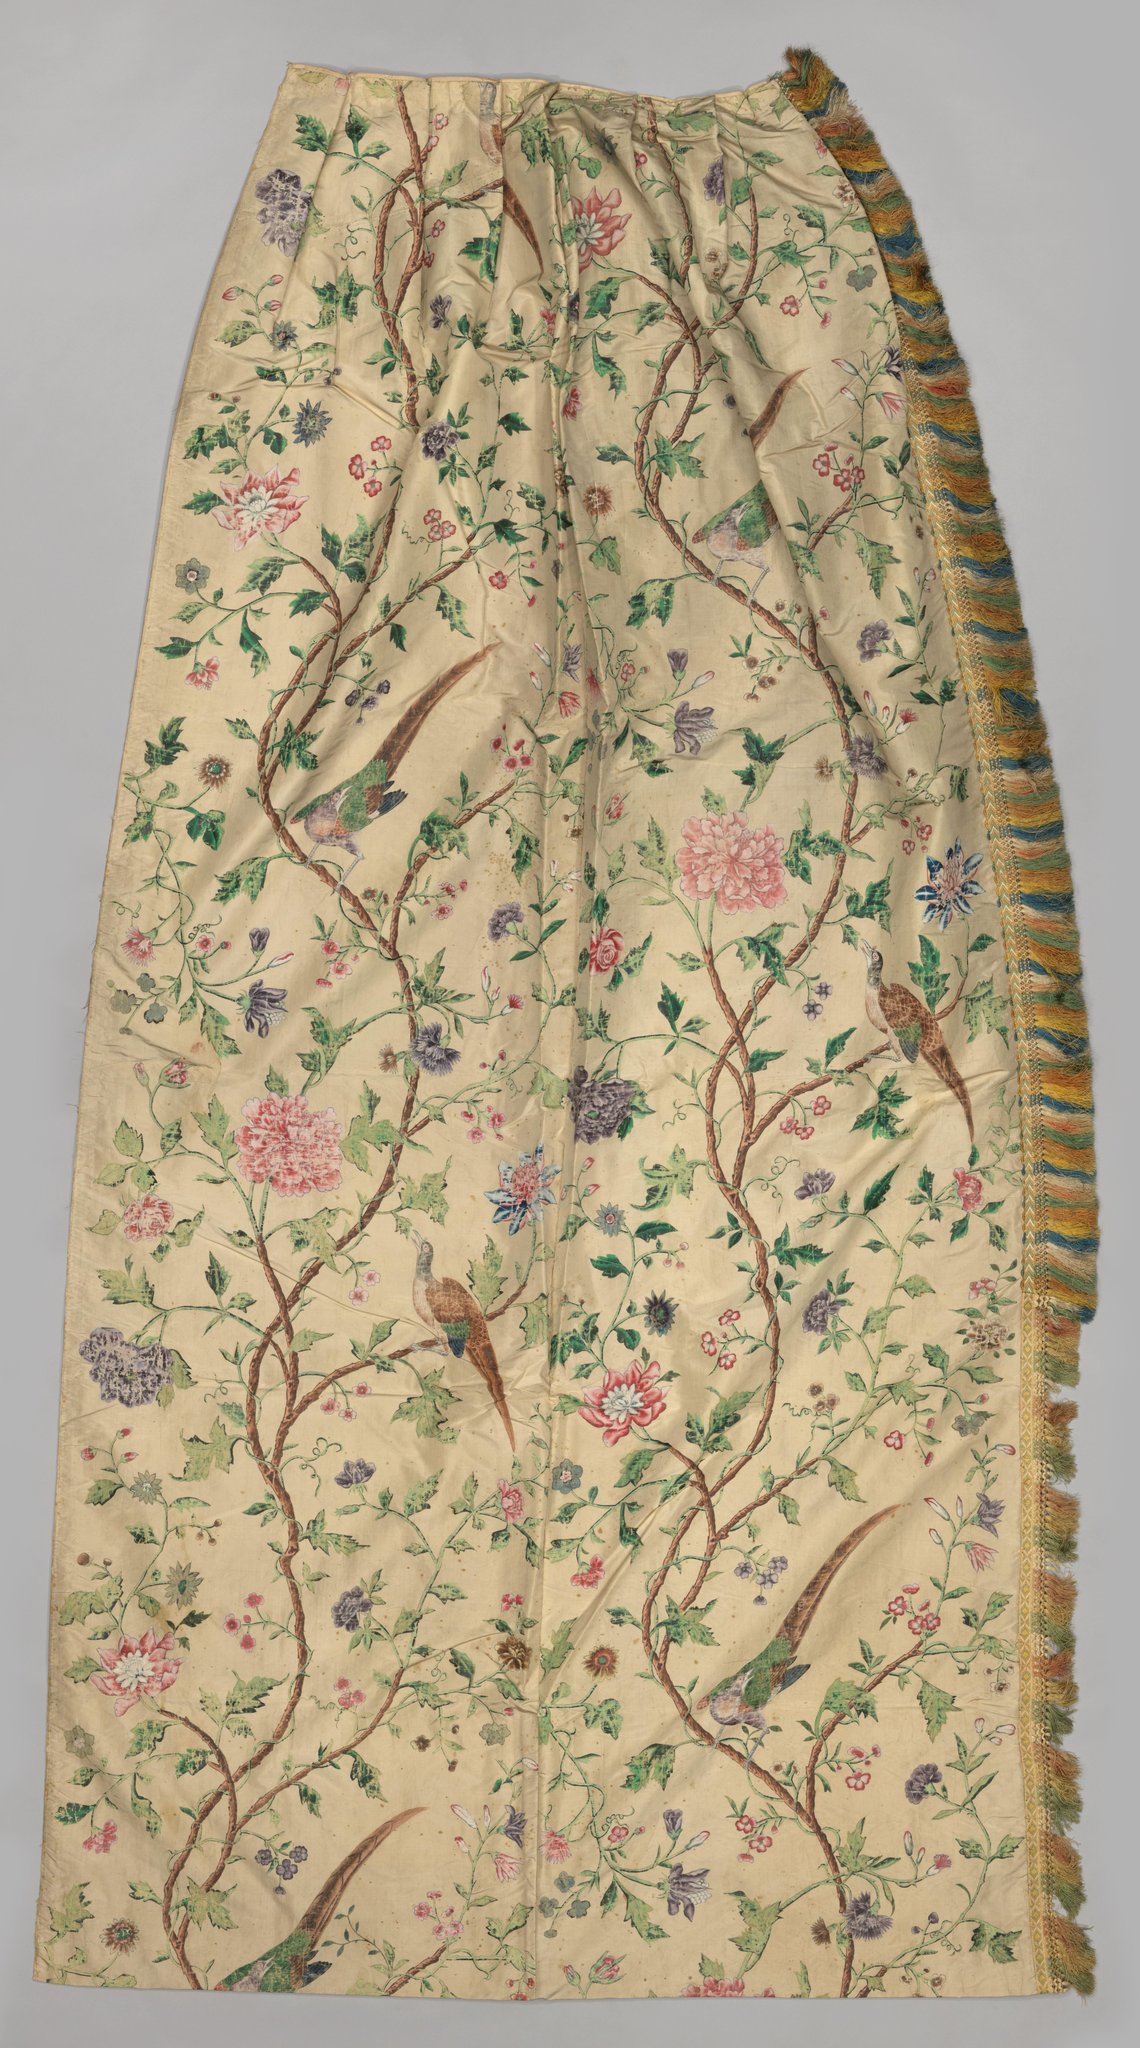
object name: silk textile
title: Gordijn van beschilderde zijde versierd met bloemen en vogels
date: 1750-1775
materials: cotton, silk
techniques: rib binding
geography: france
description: Gordijn van beschilderde zijde. Op een fijne witte ripszijde werd een contourtekening gedrukt en een beschildering in kleuren met de hand (?) aangebracht, waarvan het patroon bestaat uit een opgaande golvende vertakte en bloeiende stengel, waarop twee fazanten zijn gezeten en waaromheen zich een groene rank slingert. De bloemen zijn: lotus van rood en wit grote paarse en rozerode pioen, lotus van blauw en roze, paarse en rose anjer en fantasiebloemen in rose, paars, geel en bleu. De bladeren gelijken op die van chrysanten. Het gordijn bestaat uit twee banen. Het heeft langs de zijkanten korte en langs de onderkant lange franje, gestreept gekleurd van groen, zalmkleur, geel, blauw, wit en lichtbruin, beginnende als een galon met zigzag patroon en daarna geknoopt. Voering van fijne gekeperde lichtbruine katoen en 20e eeuwse shantung; onder de lange franje voering van wit satinet.